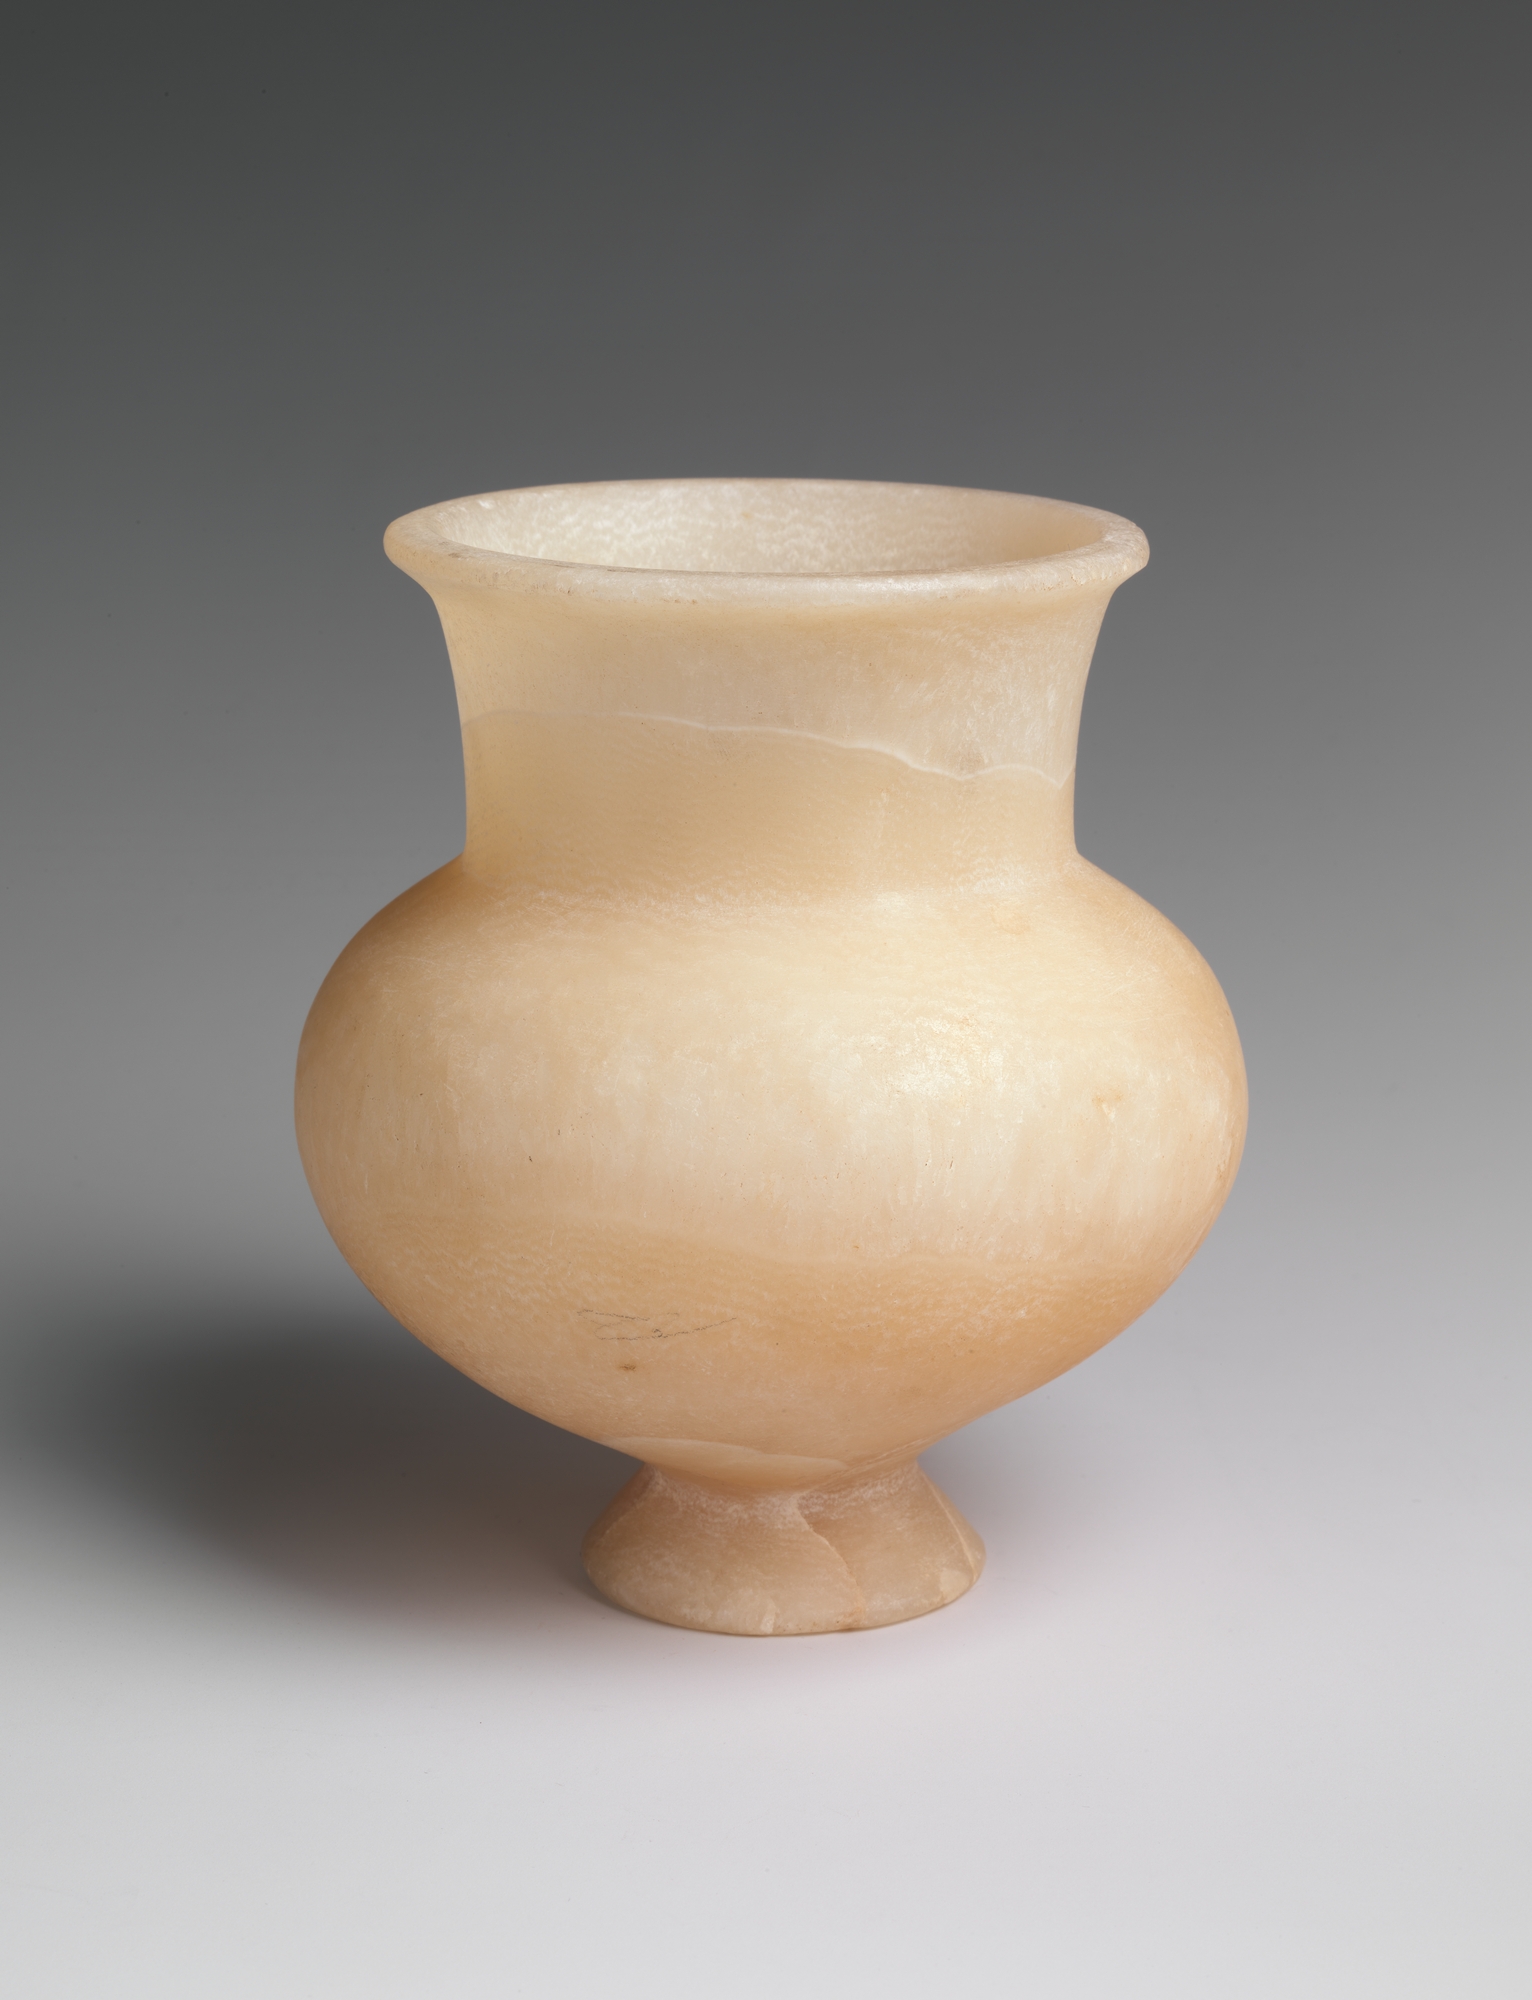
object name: jar, long necked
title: Wide-Necked Cosmetic Jar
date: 1550-1450 BCE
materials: stone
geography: egypt